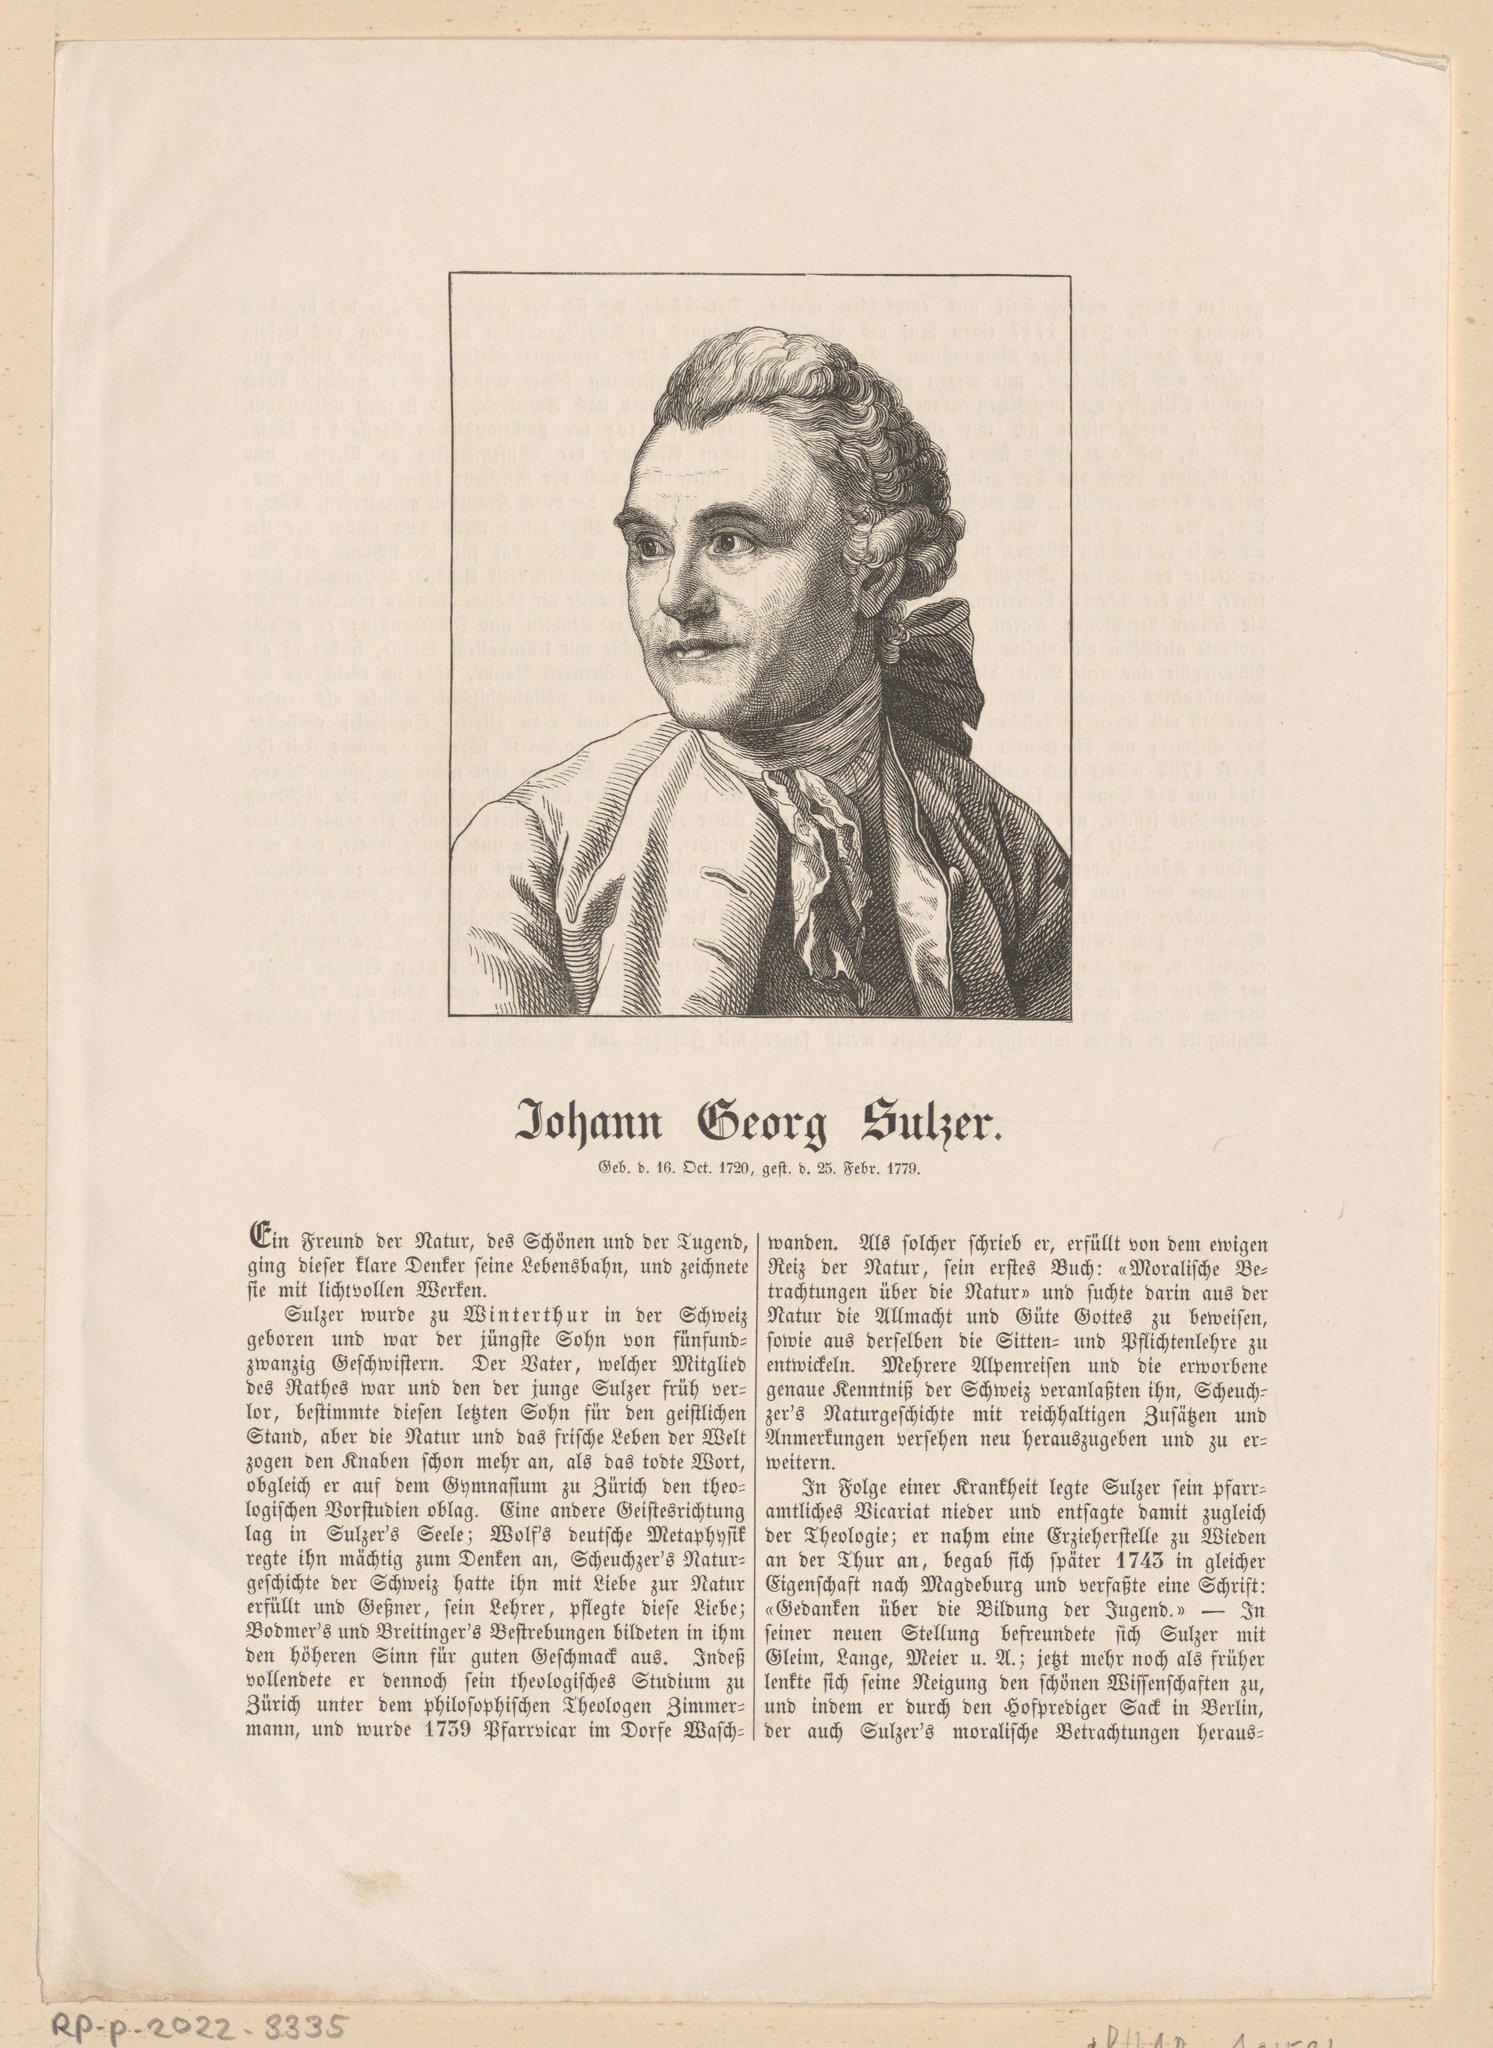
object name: book illustration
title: Portret van Johann Georg Sulzer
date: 1854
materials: paper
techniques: letterpress printing, engraving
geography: germany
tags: berlin, scholar, philosopher, historical persons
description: Prent uit: Bechstein, Ludwig. Zweihundert deutsche Männer in Bildnissen und Lebensbeschreibungen. Leipzig: Georg Wigand, 1854.